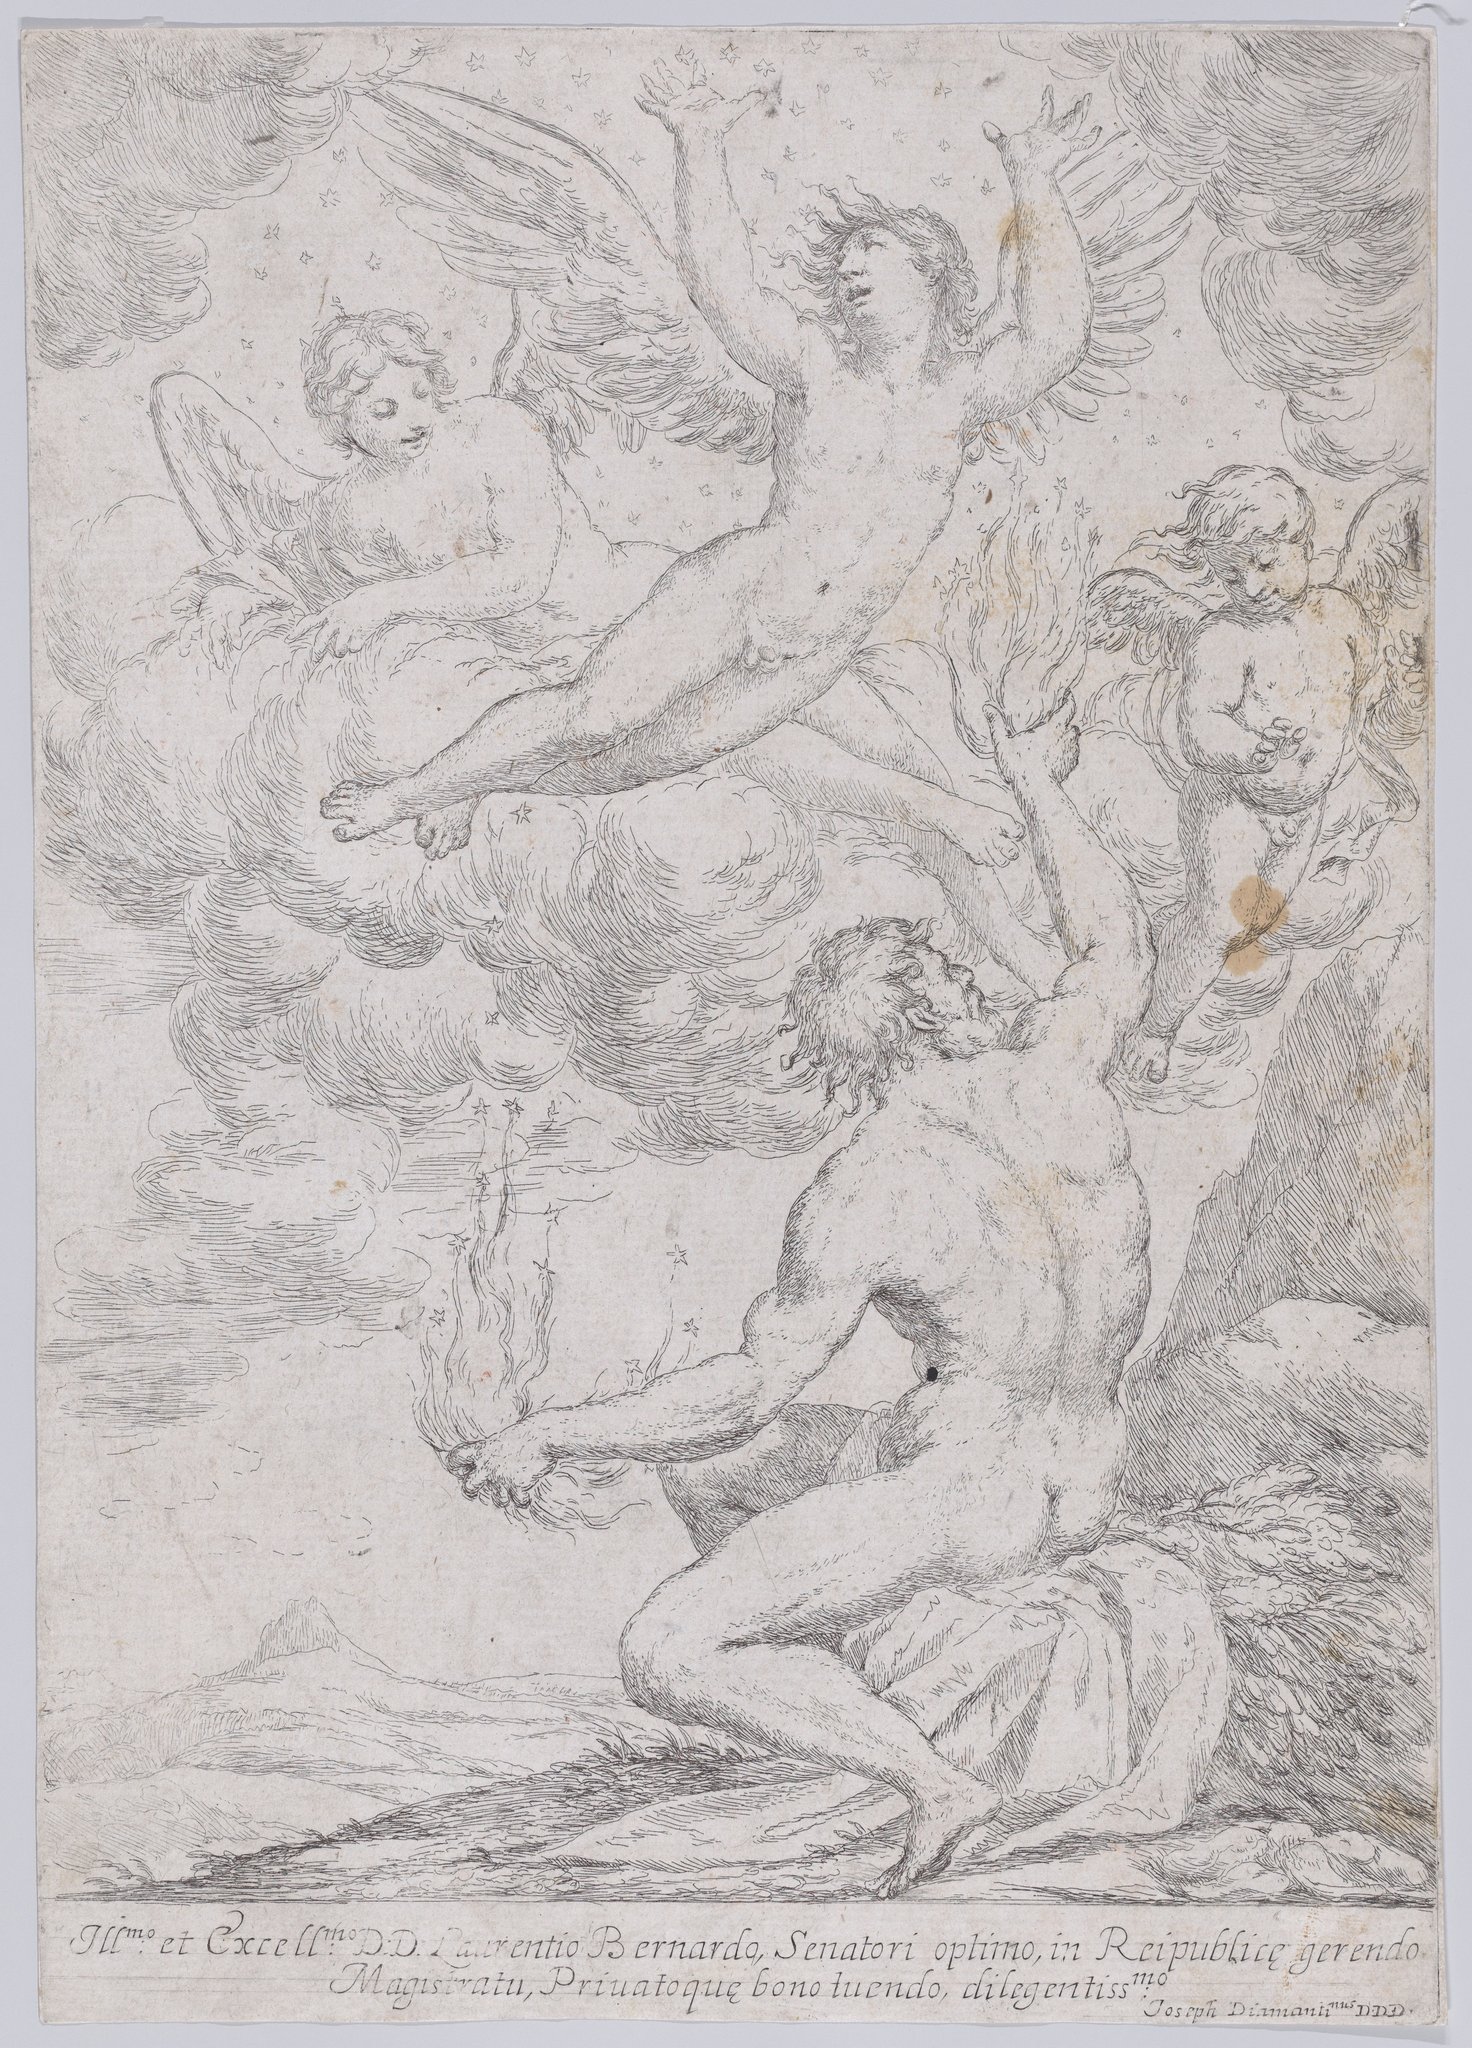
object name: print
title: The Fall of Icarus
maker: giuseppe diamantini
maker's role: artist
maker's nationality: italian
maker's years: 1621-1705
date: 1650-1700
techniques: etching